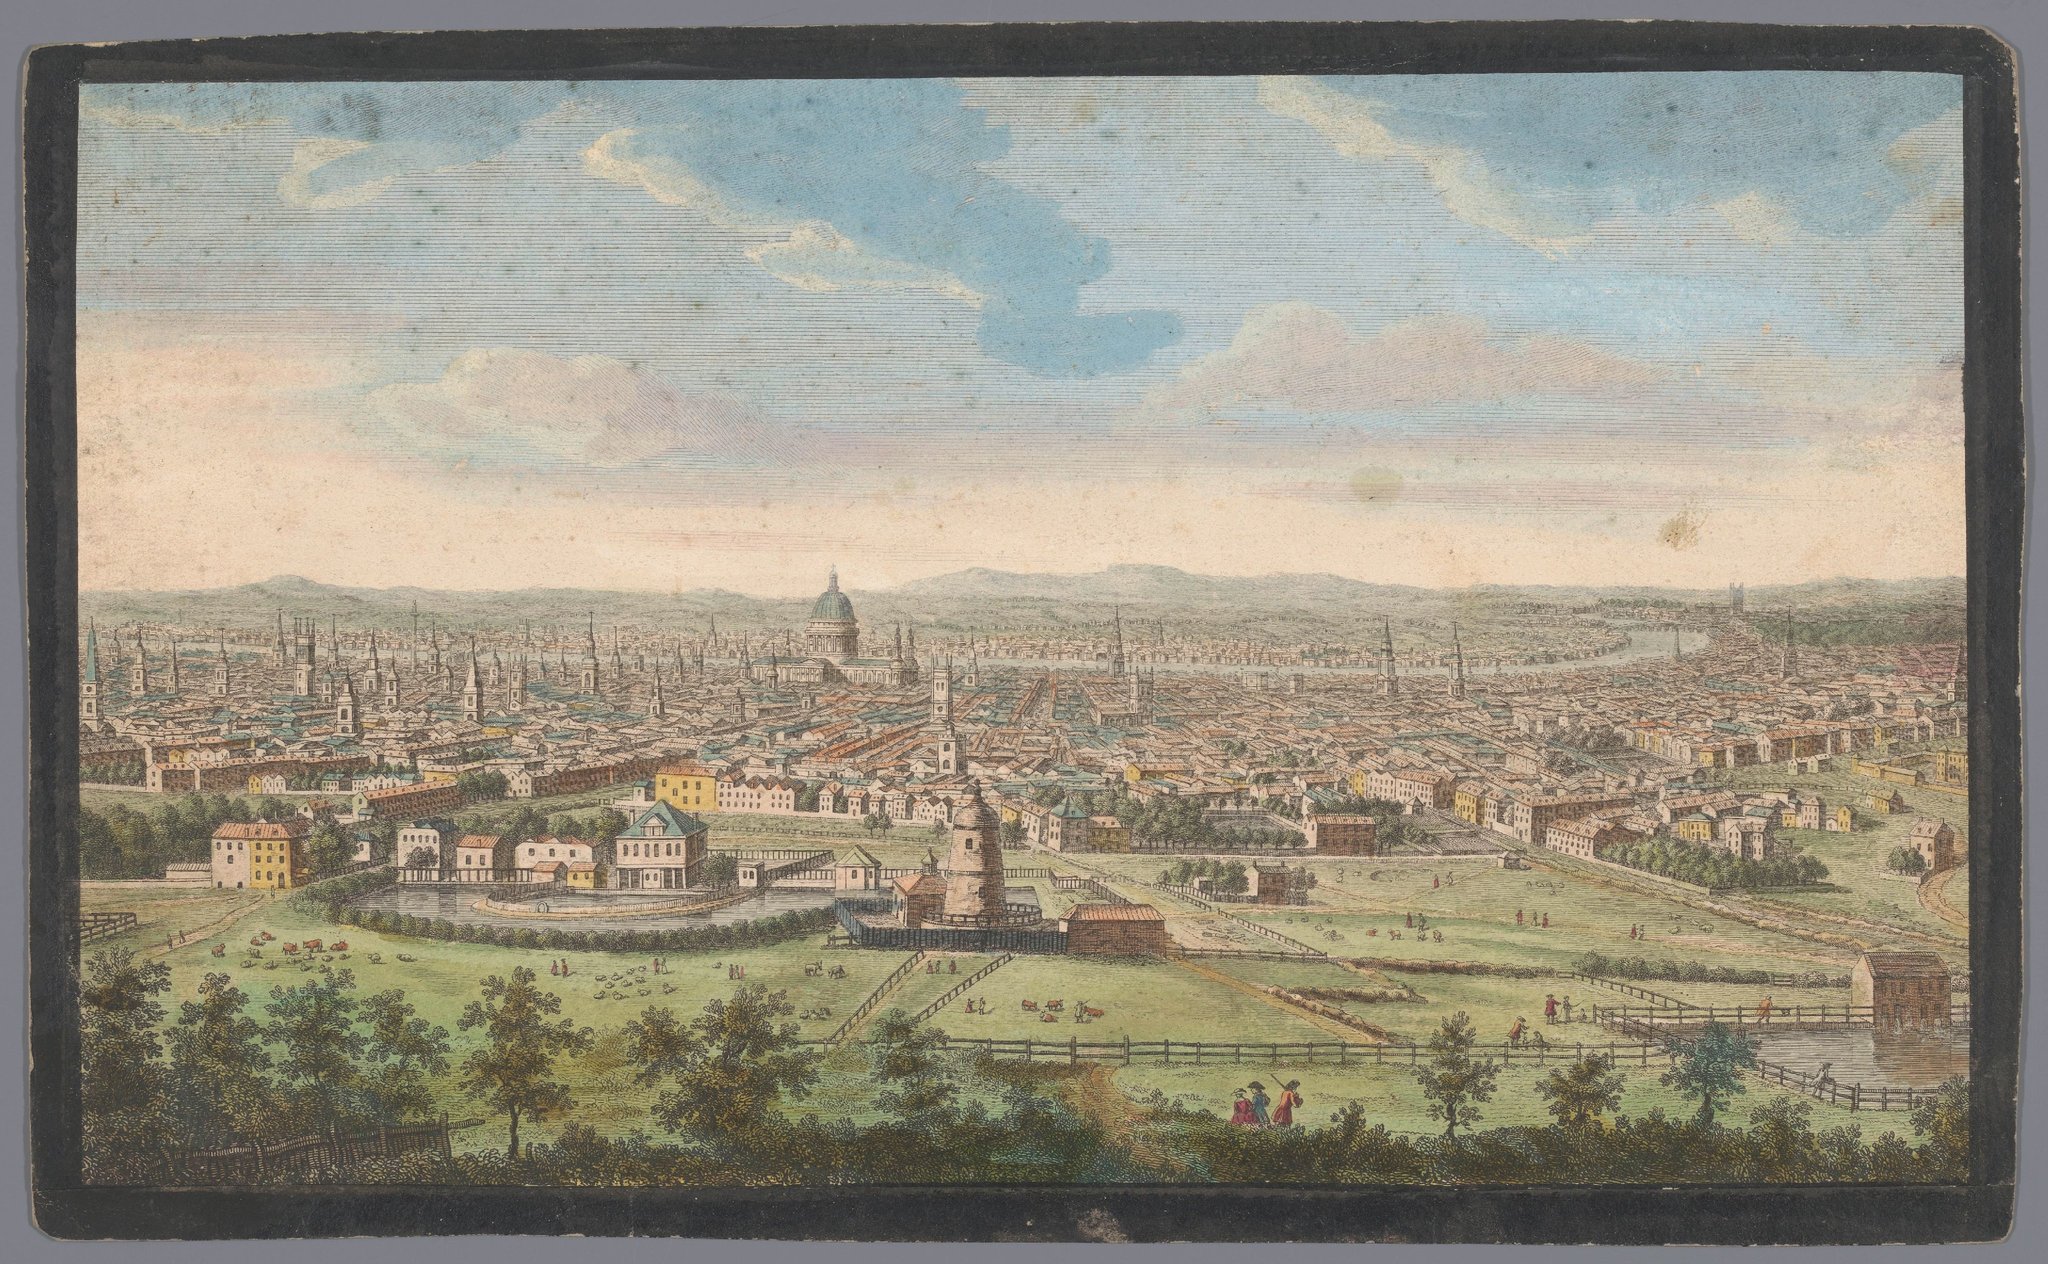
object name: opticaprent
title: Londen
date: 1753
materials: cardboard, paper, watercolor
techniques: brush, etching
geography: london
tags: church (exterior), city-view in general; 'veduta' (+ city(-scape) with figures, staffage), london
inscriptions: collector's mark: Lugt 2233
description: De serie “Londen” bevat 52 prenten met de nummers 1-52, waarvan dit nummer 2 is.